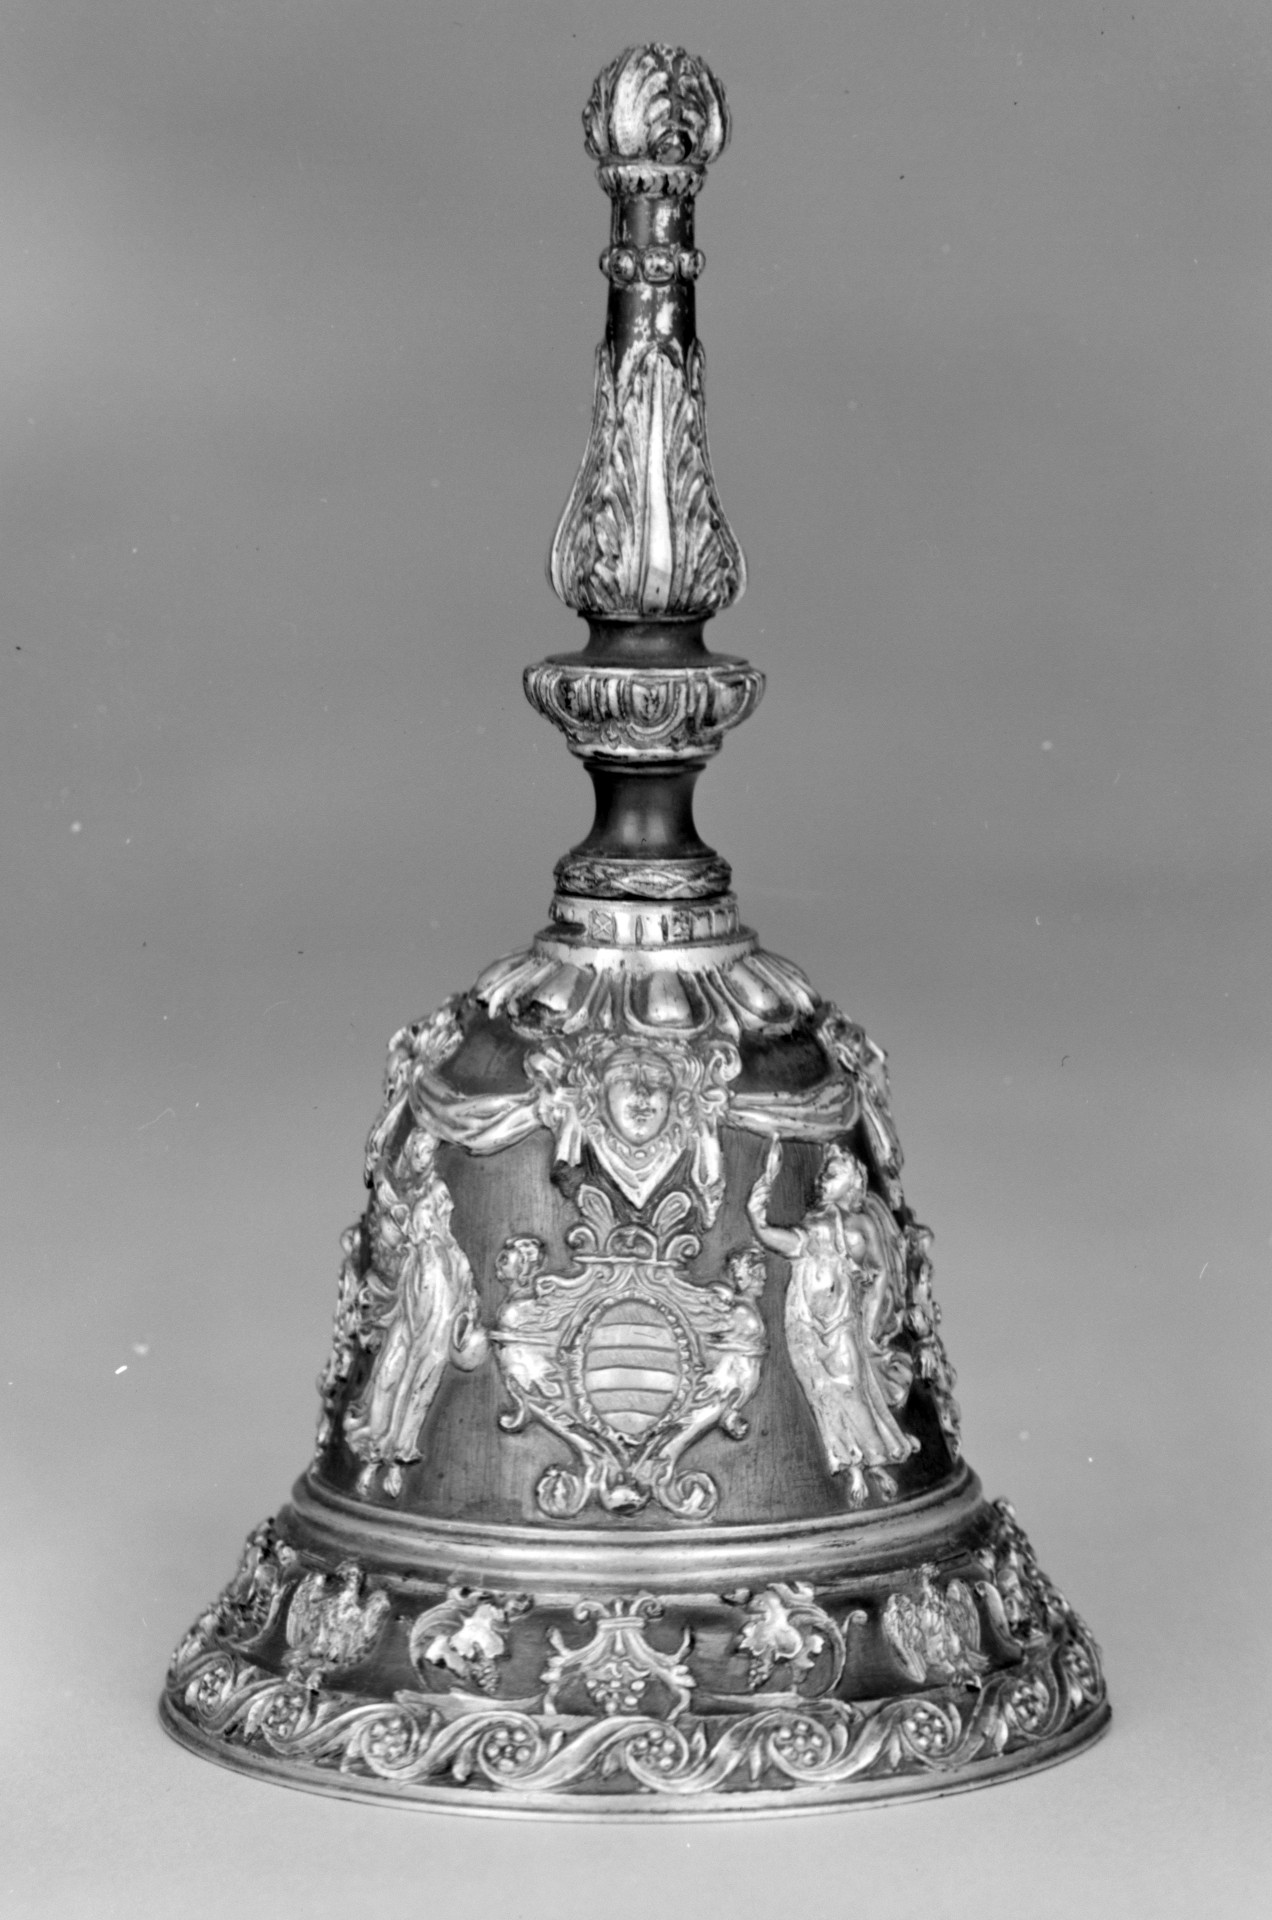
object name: table bell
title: Renaissance-style table bell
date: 1801-1900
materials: bronze, gilt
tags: human figures,musical instruments